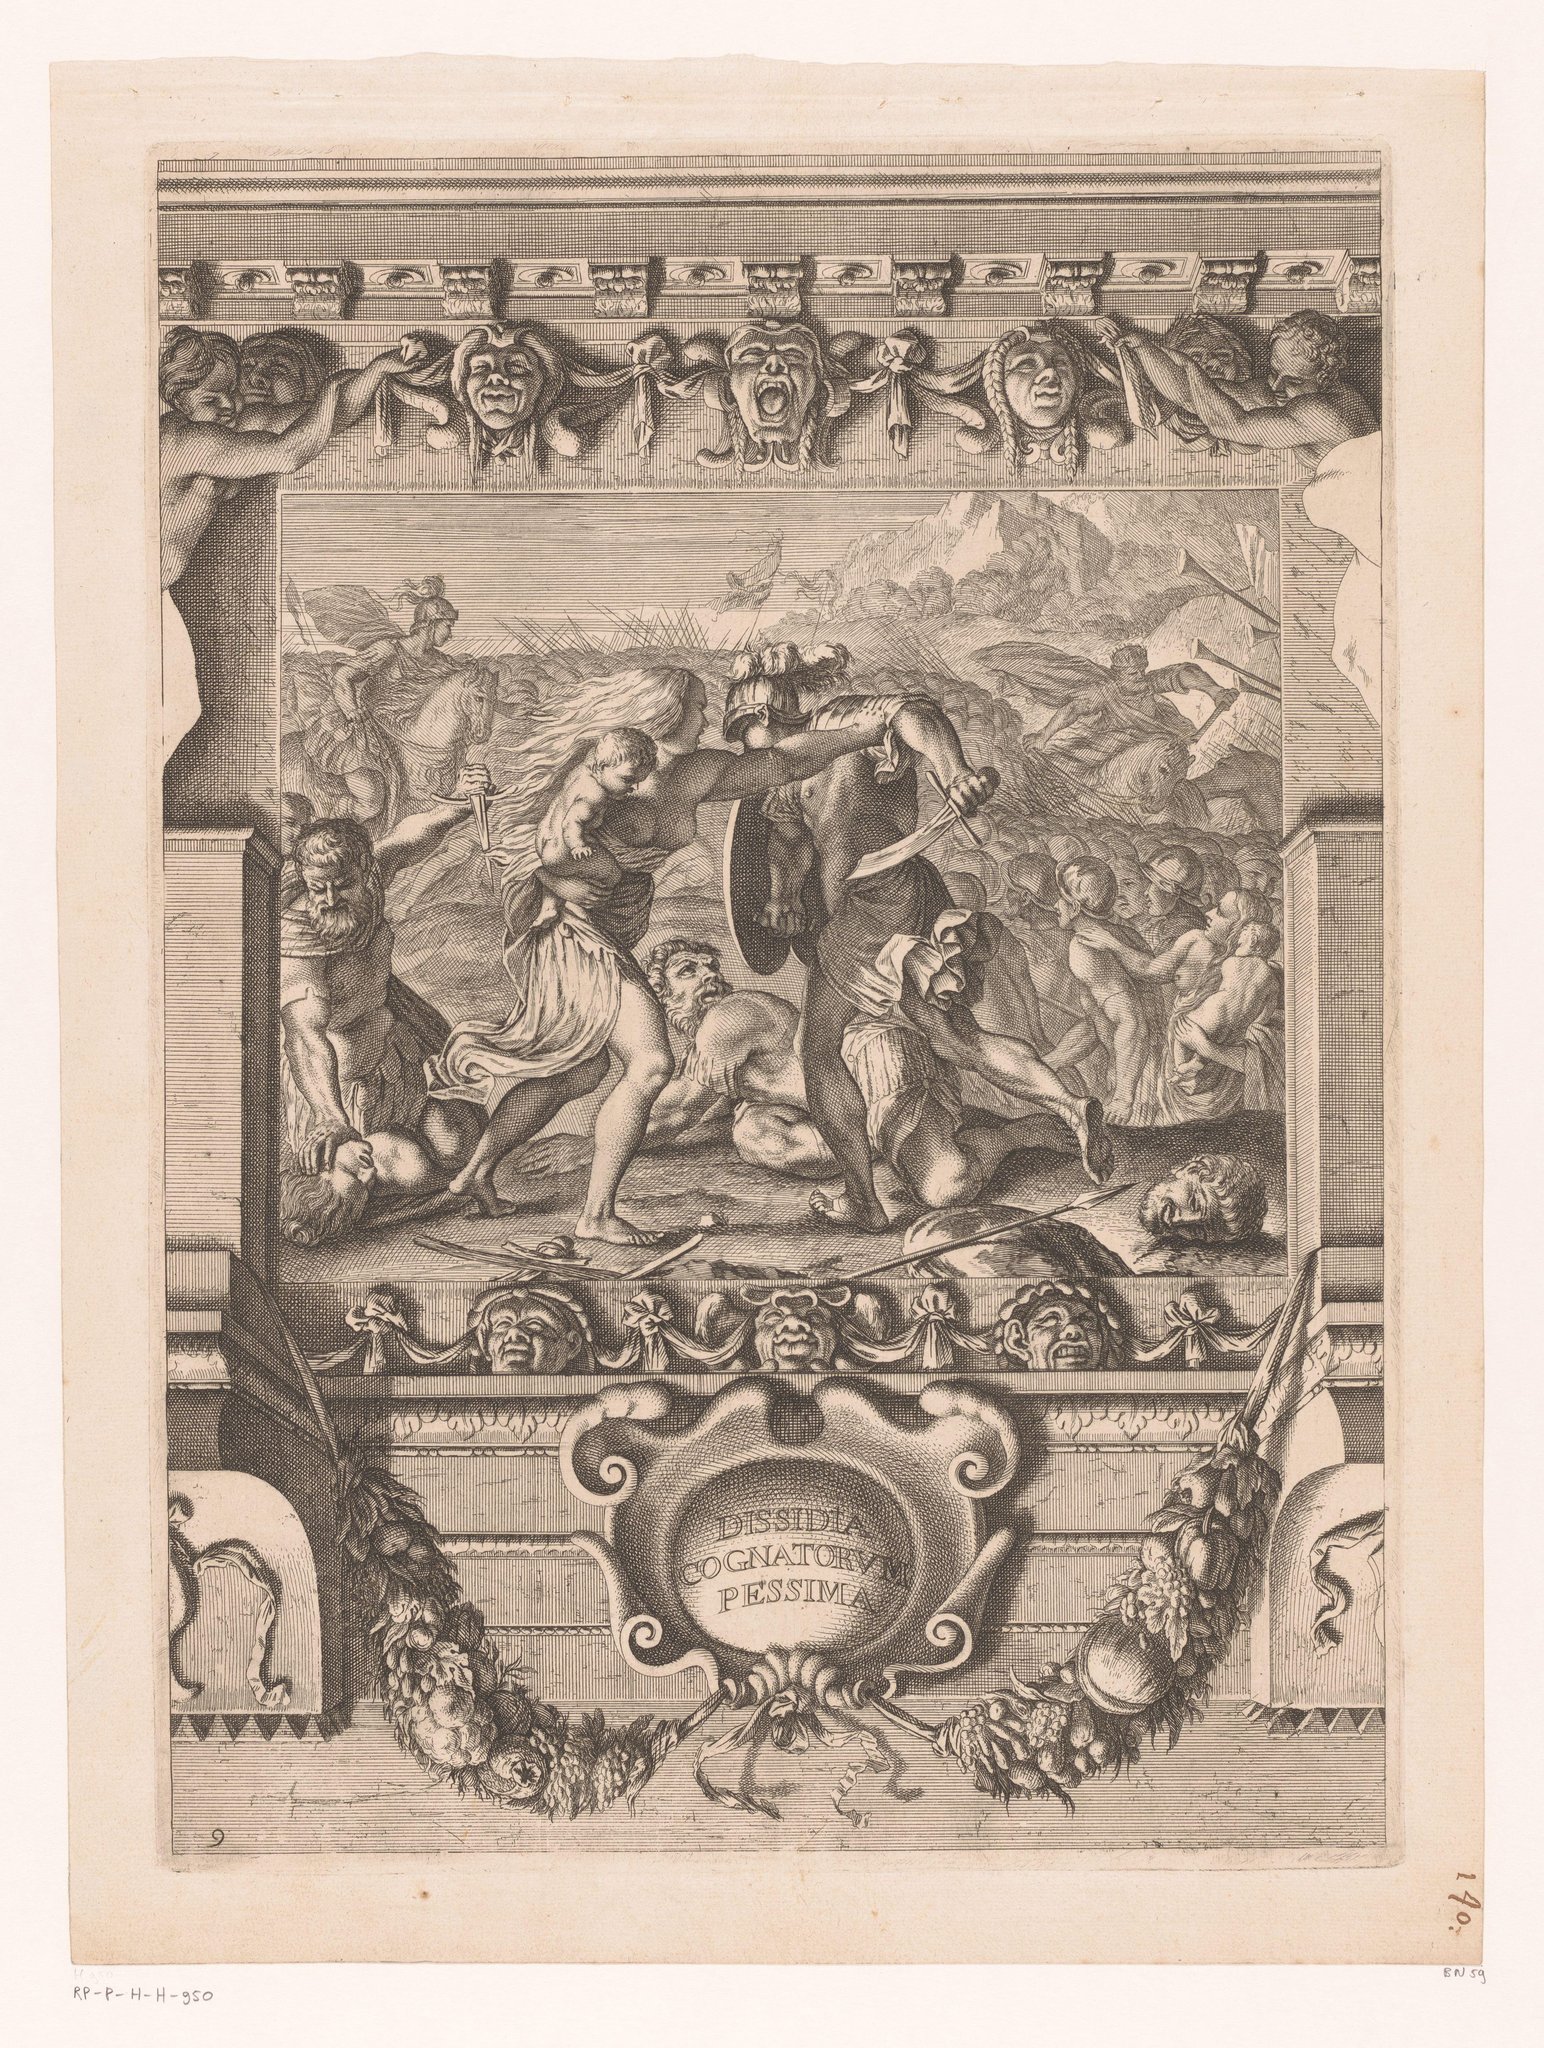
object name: print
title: Verzoening tussen de Romeinen en de Sabijnen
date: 1659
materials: paper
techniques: engraving, etching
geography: paris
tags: reconciliation of the sabines and the romans: the women, some holding their babies, others with their hair loose, and possibly encouraged by hersilia call for peace in the midst of the two fighting armies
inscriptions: number: ‘141.’, number: ‘140.’, collector's mark: Lugt 11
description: Maakt deel uit van een 14-delige serie met scènes uit het verhaal van Romulus en Remus naar ontwerpen door de familie Carracci voor het Palazzo Magnani te Bologna. Prent 1 t/m 7 zijn in prent gebracht door Lepautre en Boulanger en prent 8 t/m 14 door De Châtillon.